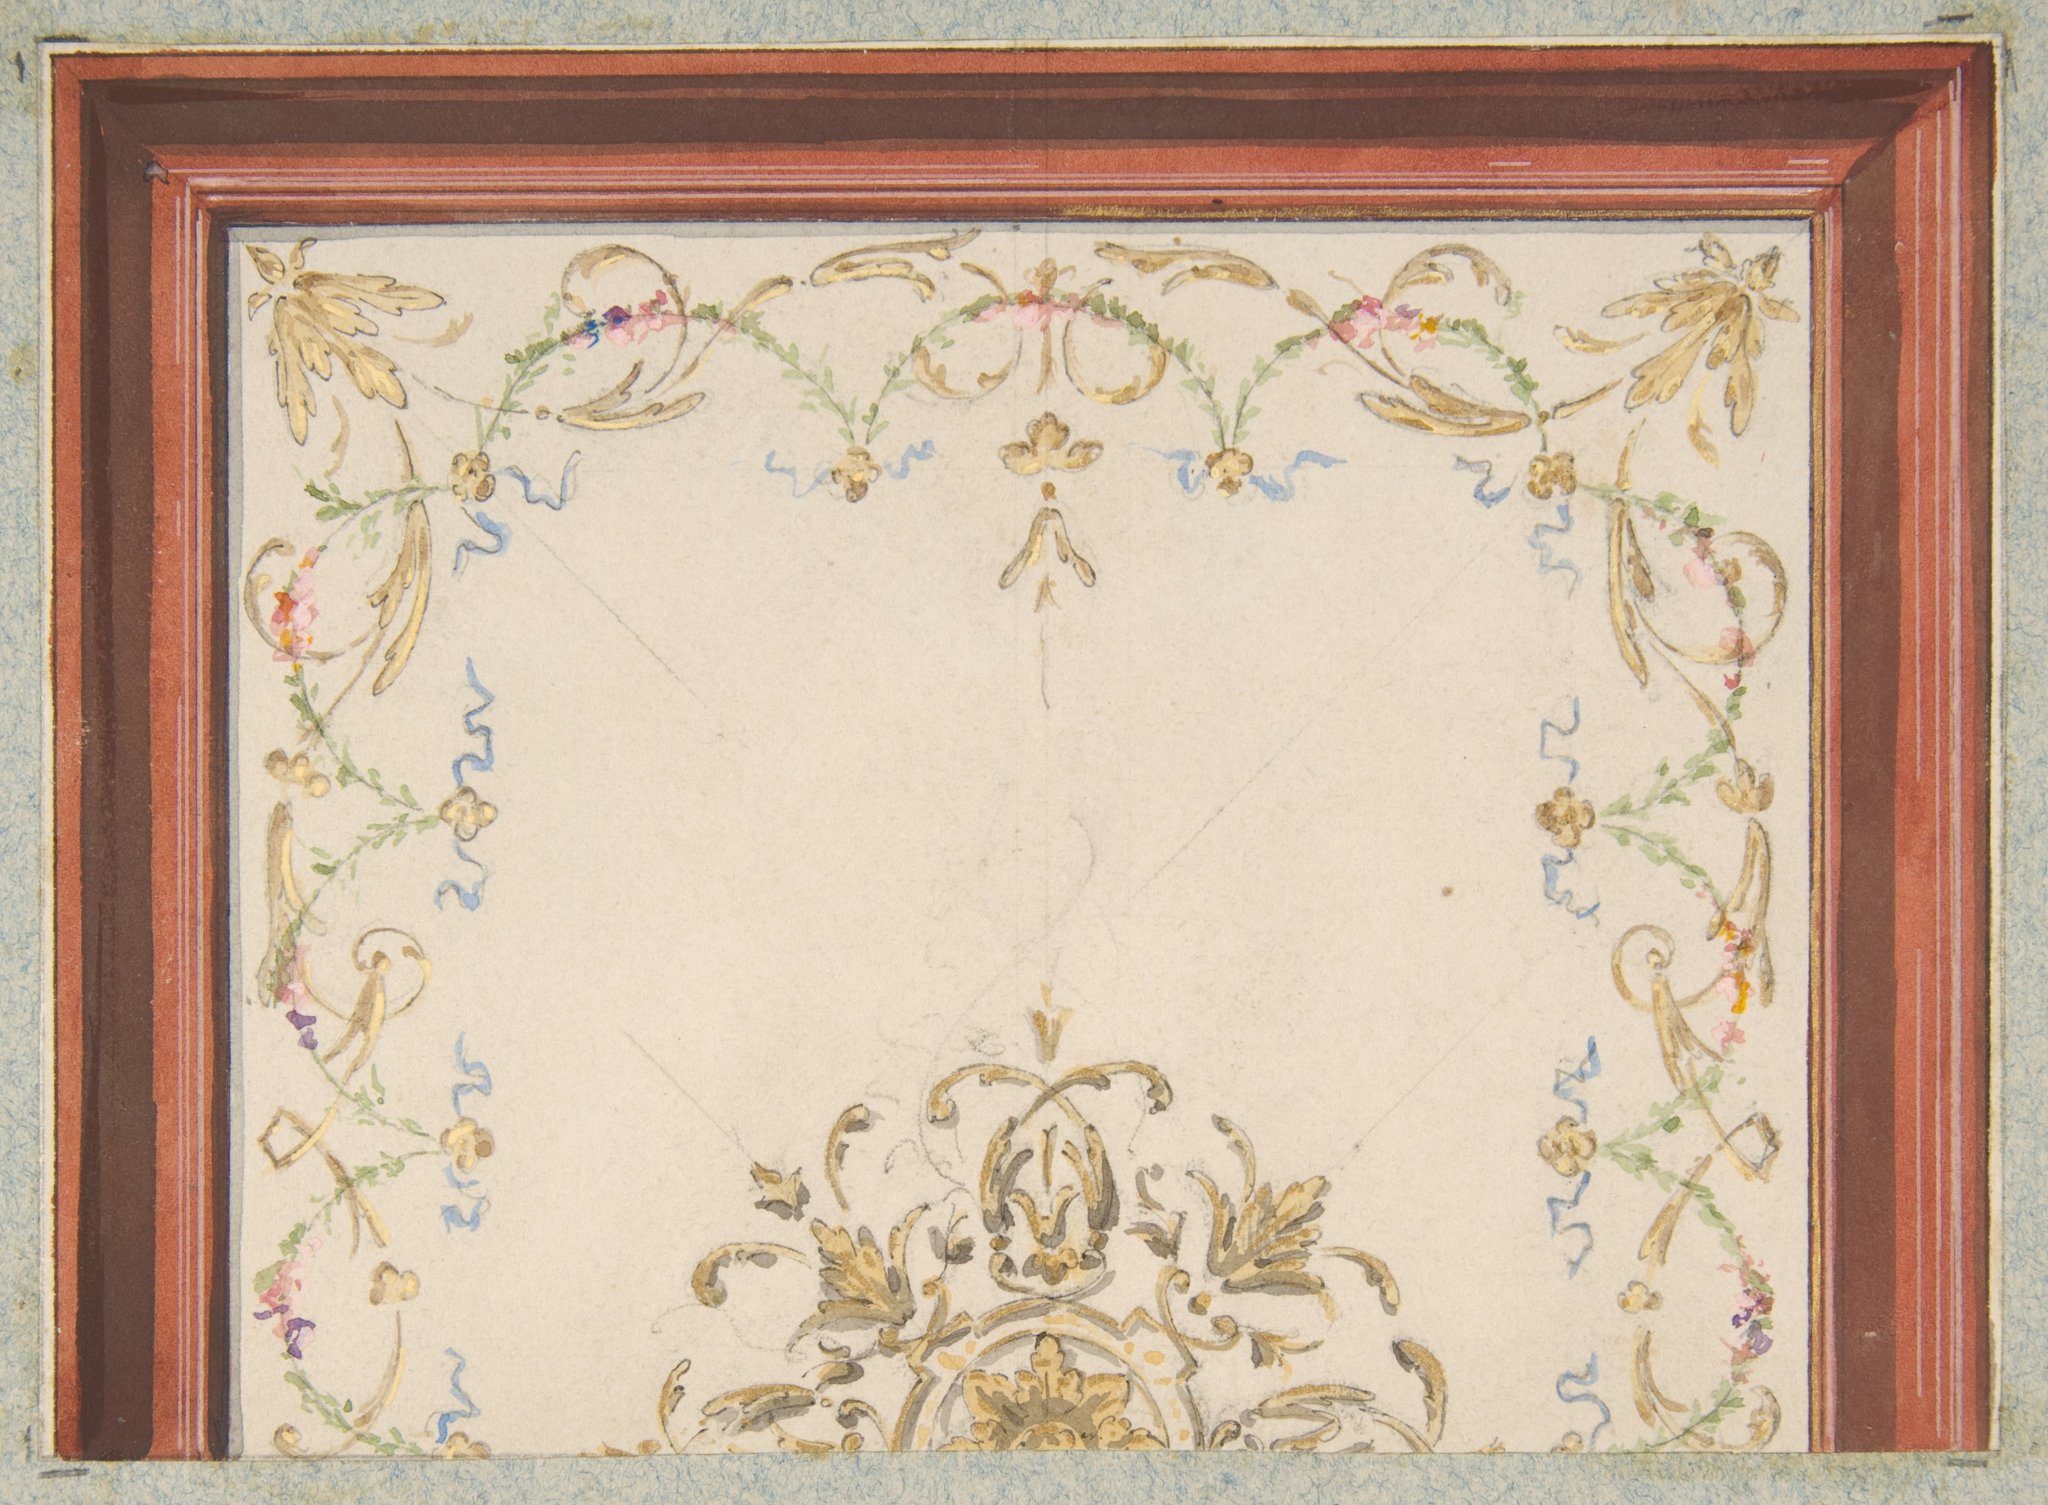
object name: drawing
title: Design for a ceiling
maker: jules-edmond-charles lachaise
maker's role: artist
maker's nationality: french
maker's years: 1897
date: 1851-1900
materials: gilt, gouache, graphite, watercolor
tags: architecture,ornament